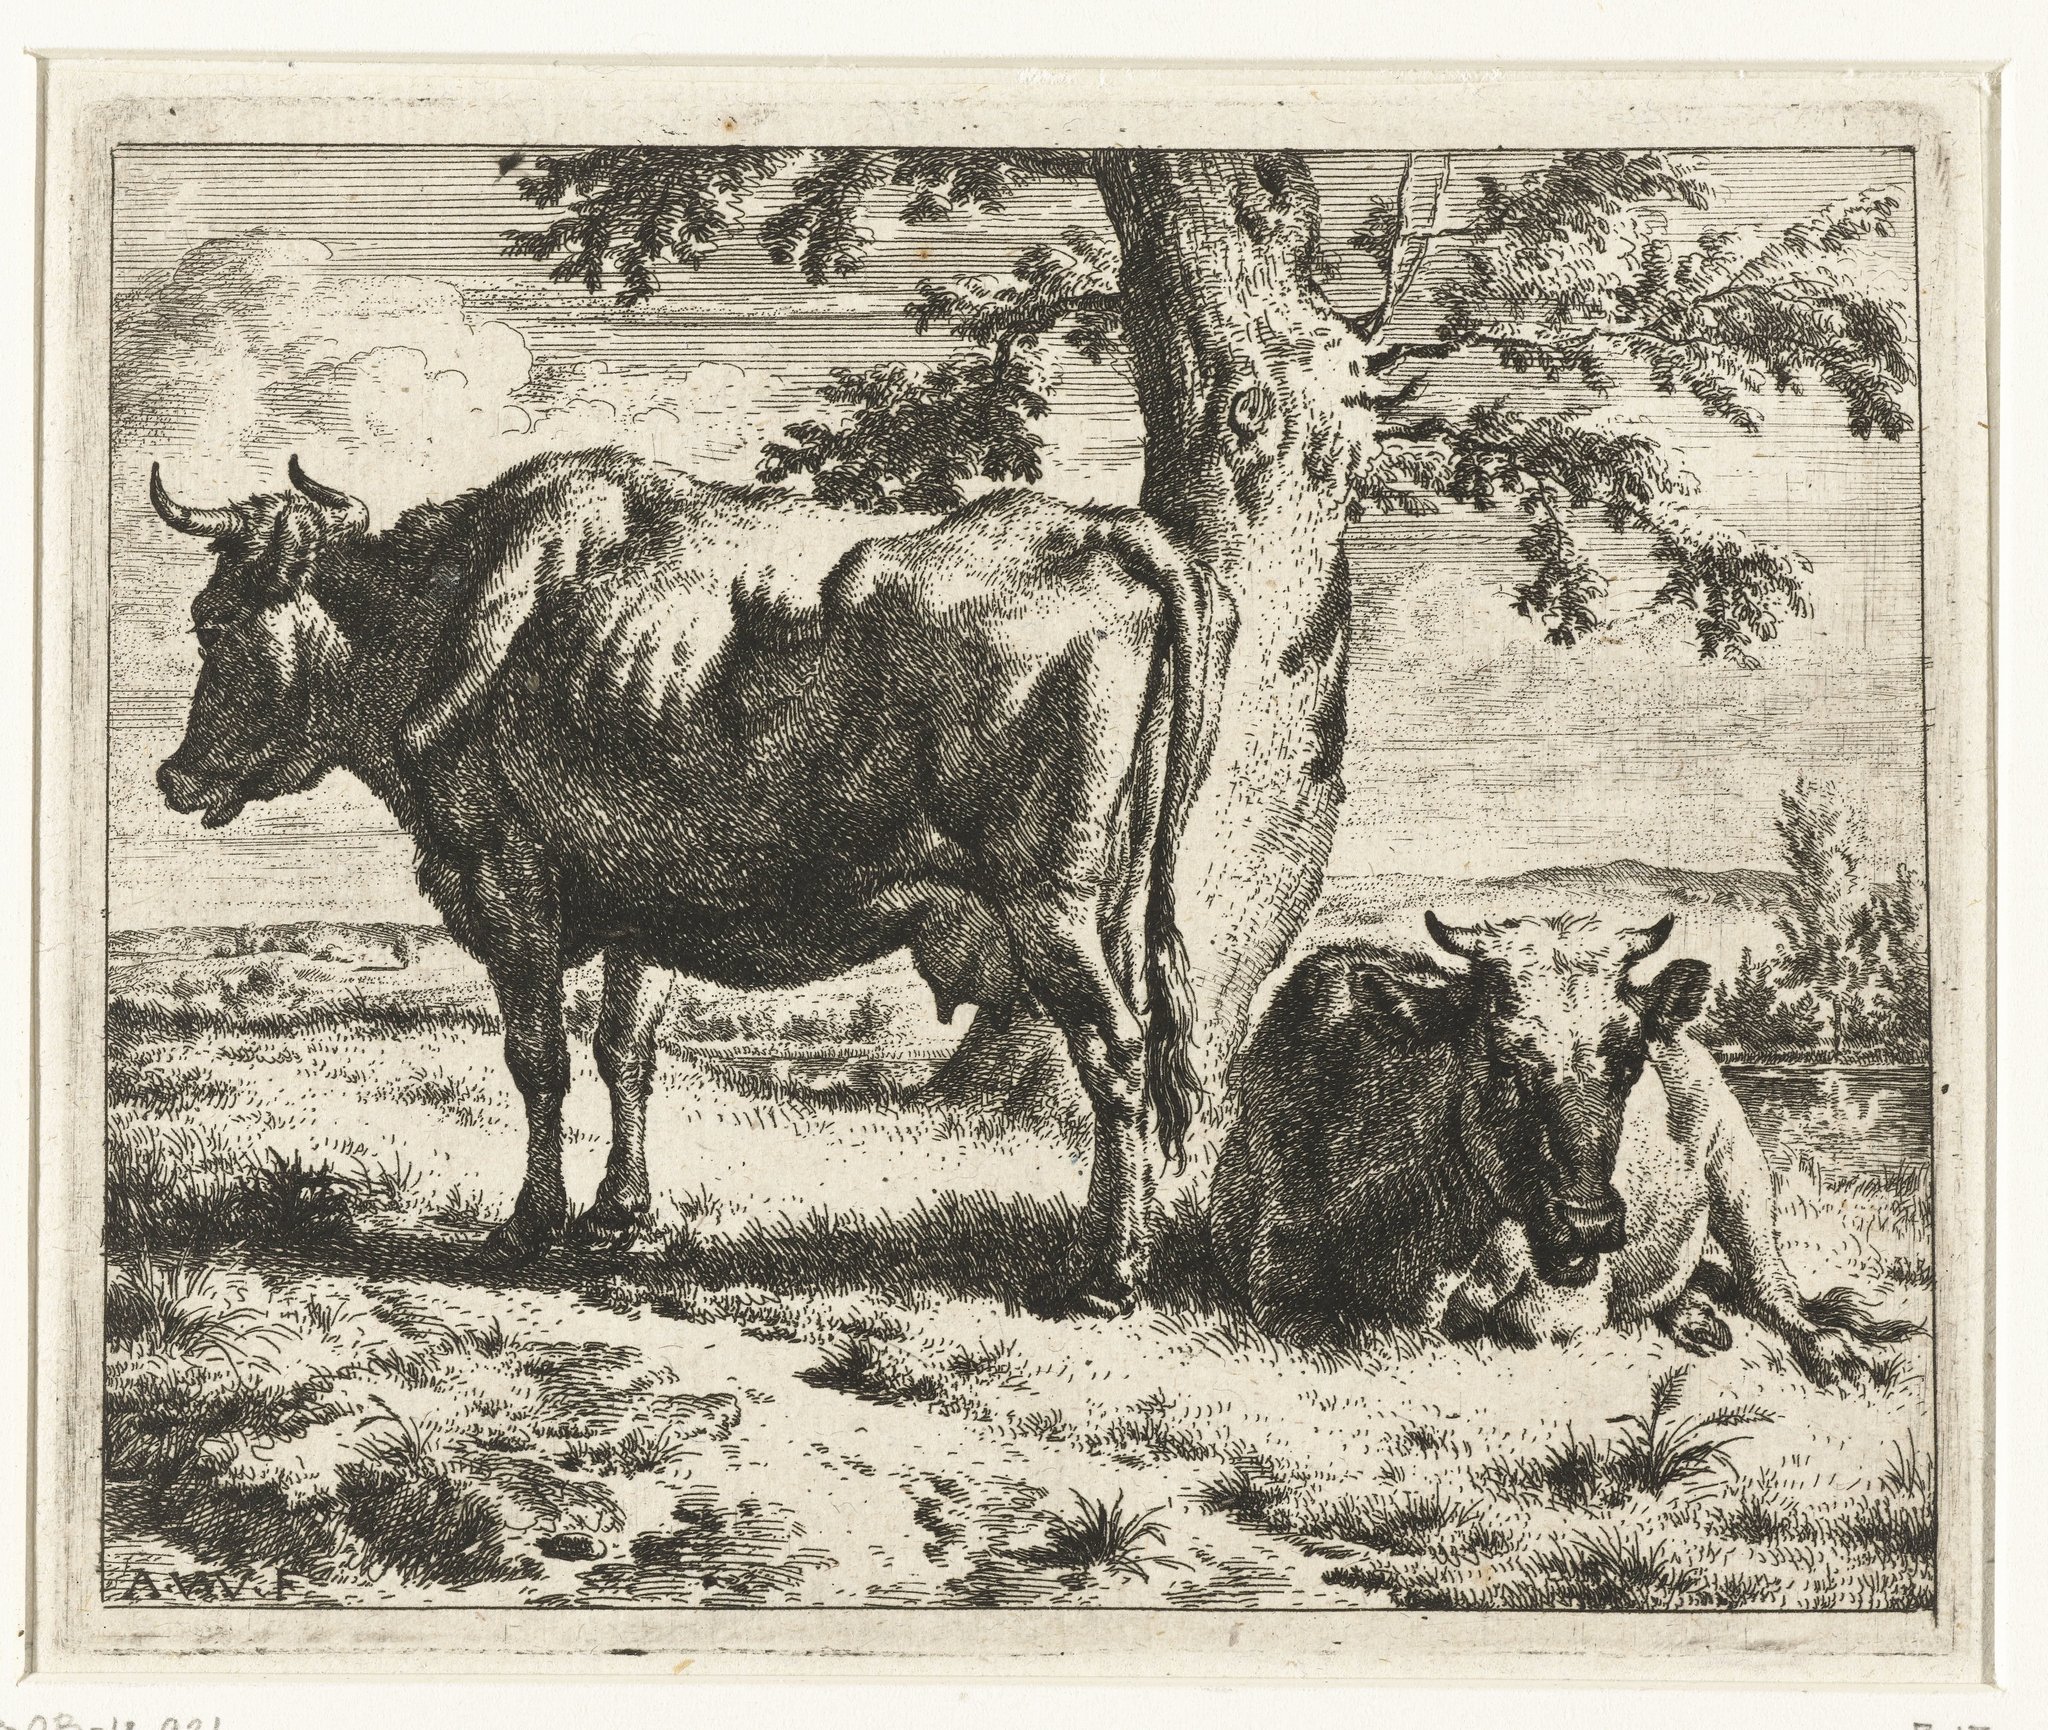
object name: print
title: Twee koeien onder een boom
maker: adriaen van de velde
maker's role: draughtsman, painter, print maker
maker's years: 1636-1672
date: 1670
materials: paper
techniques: etching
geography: amsterdam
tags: cow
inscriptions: collector's mark: Lugt 240